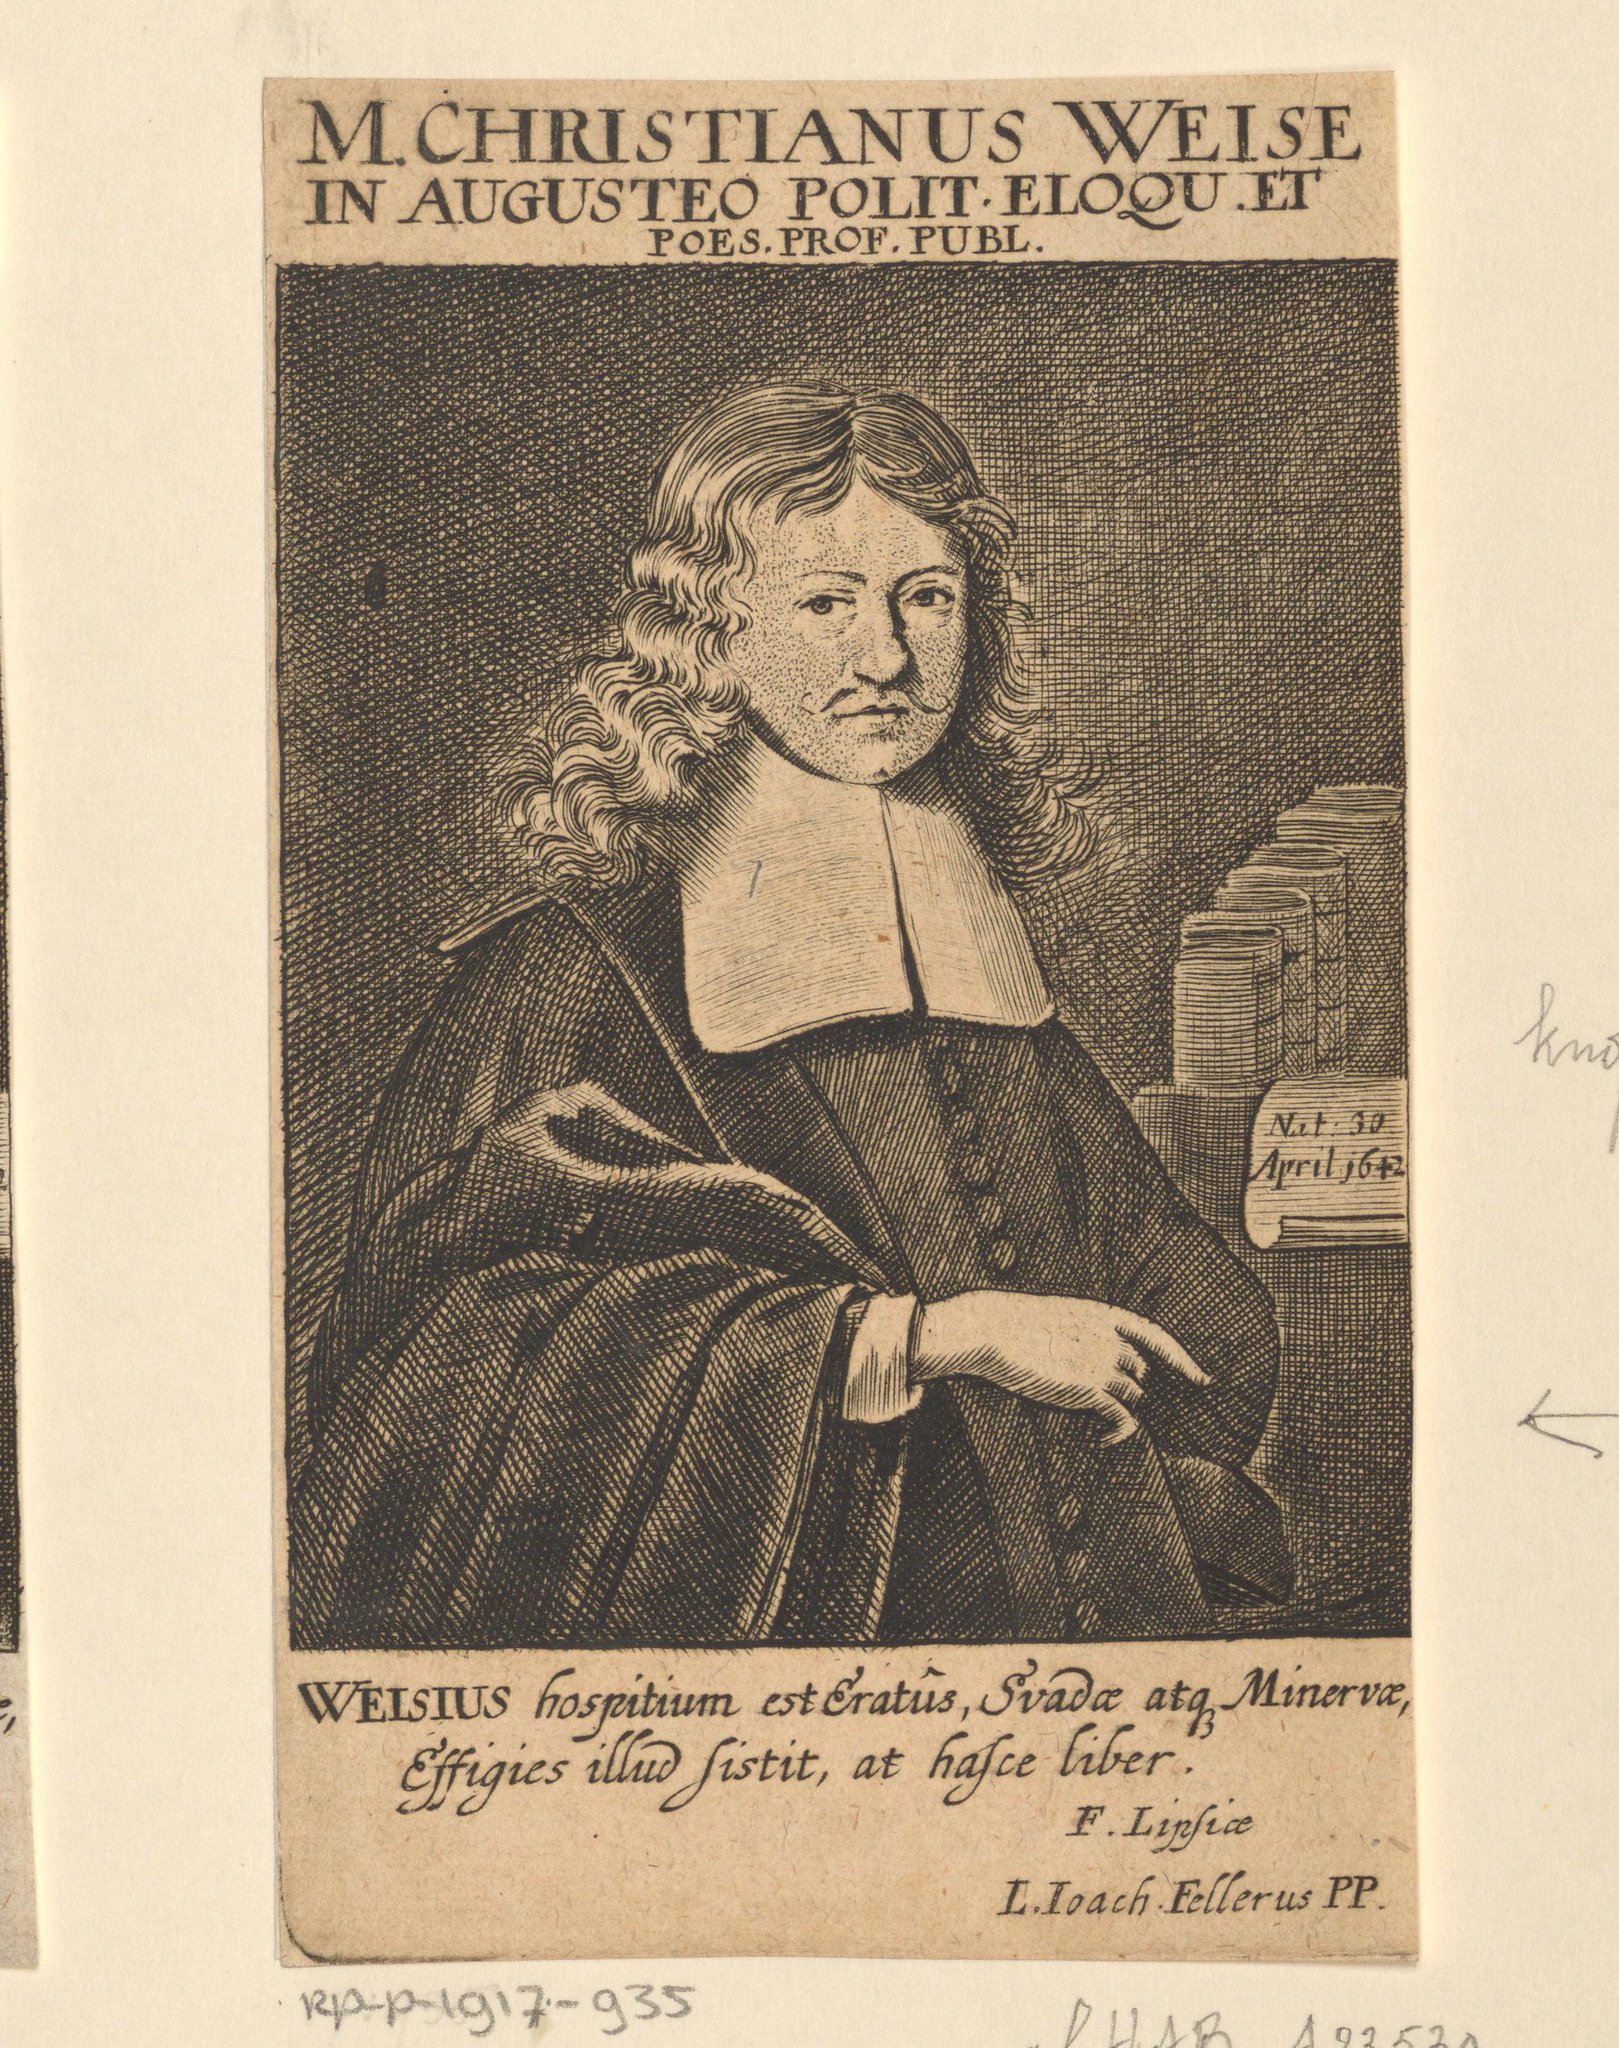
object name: print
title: Portret van Christian Weise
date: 1681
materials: paper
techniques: engraving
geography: germany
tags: bookshelves, historical persons, portrait of a writer, professor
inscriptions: collector's mark: Lugt 2228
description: Prent waarschijnlijk uit: Weise, Christian. Christian Weisens Politischer Redner, Das ist, Kurtze und eigentliche Nachricht (...). Leipzig: erven Kirschens, 1681. In andere uitgaven van dit werk zitten portretten van de auteur die erg op deze prent lijken maar wel verschillende prenten zijn, zie ook: RP-P-2022-5184 en RP-P-1917-934.